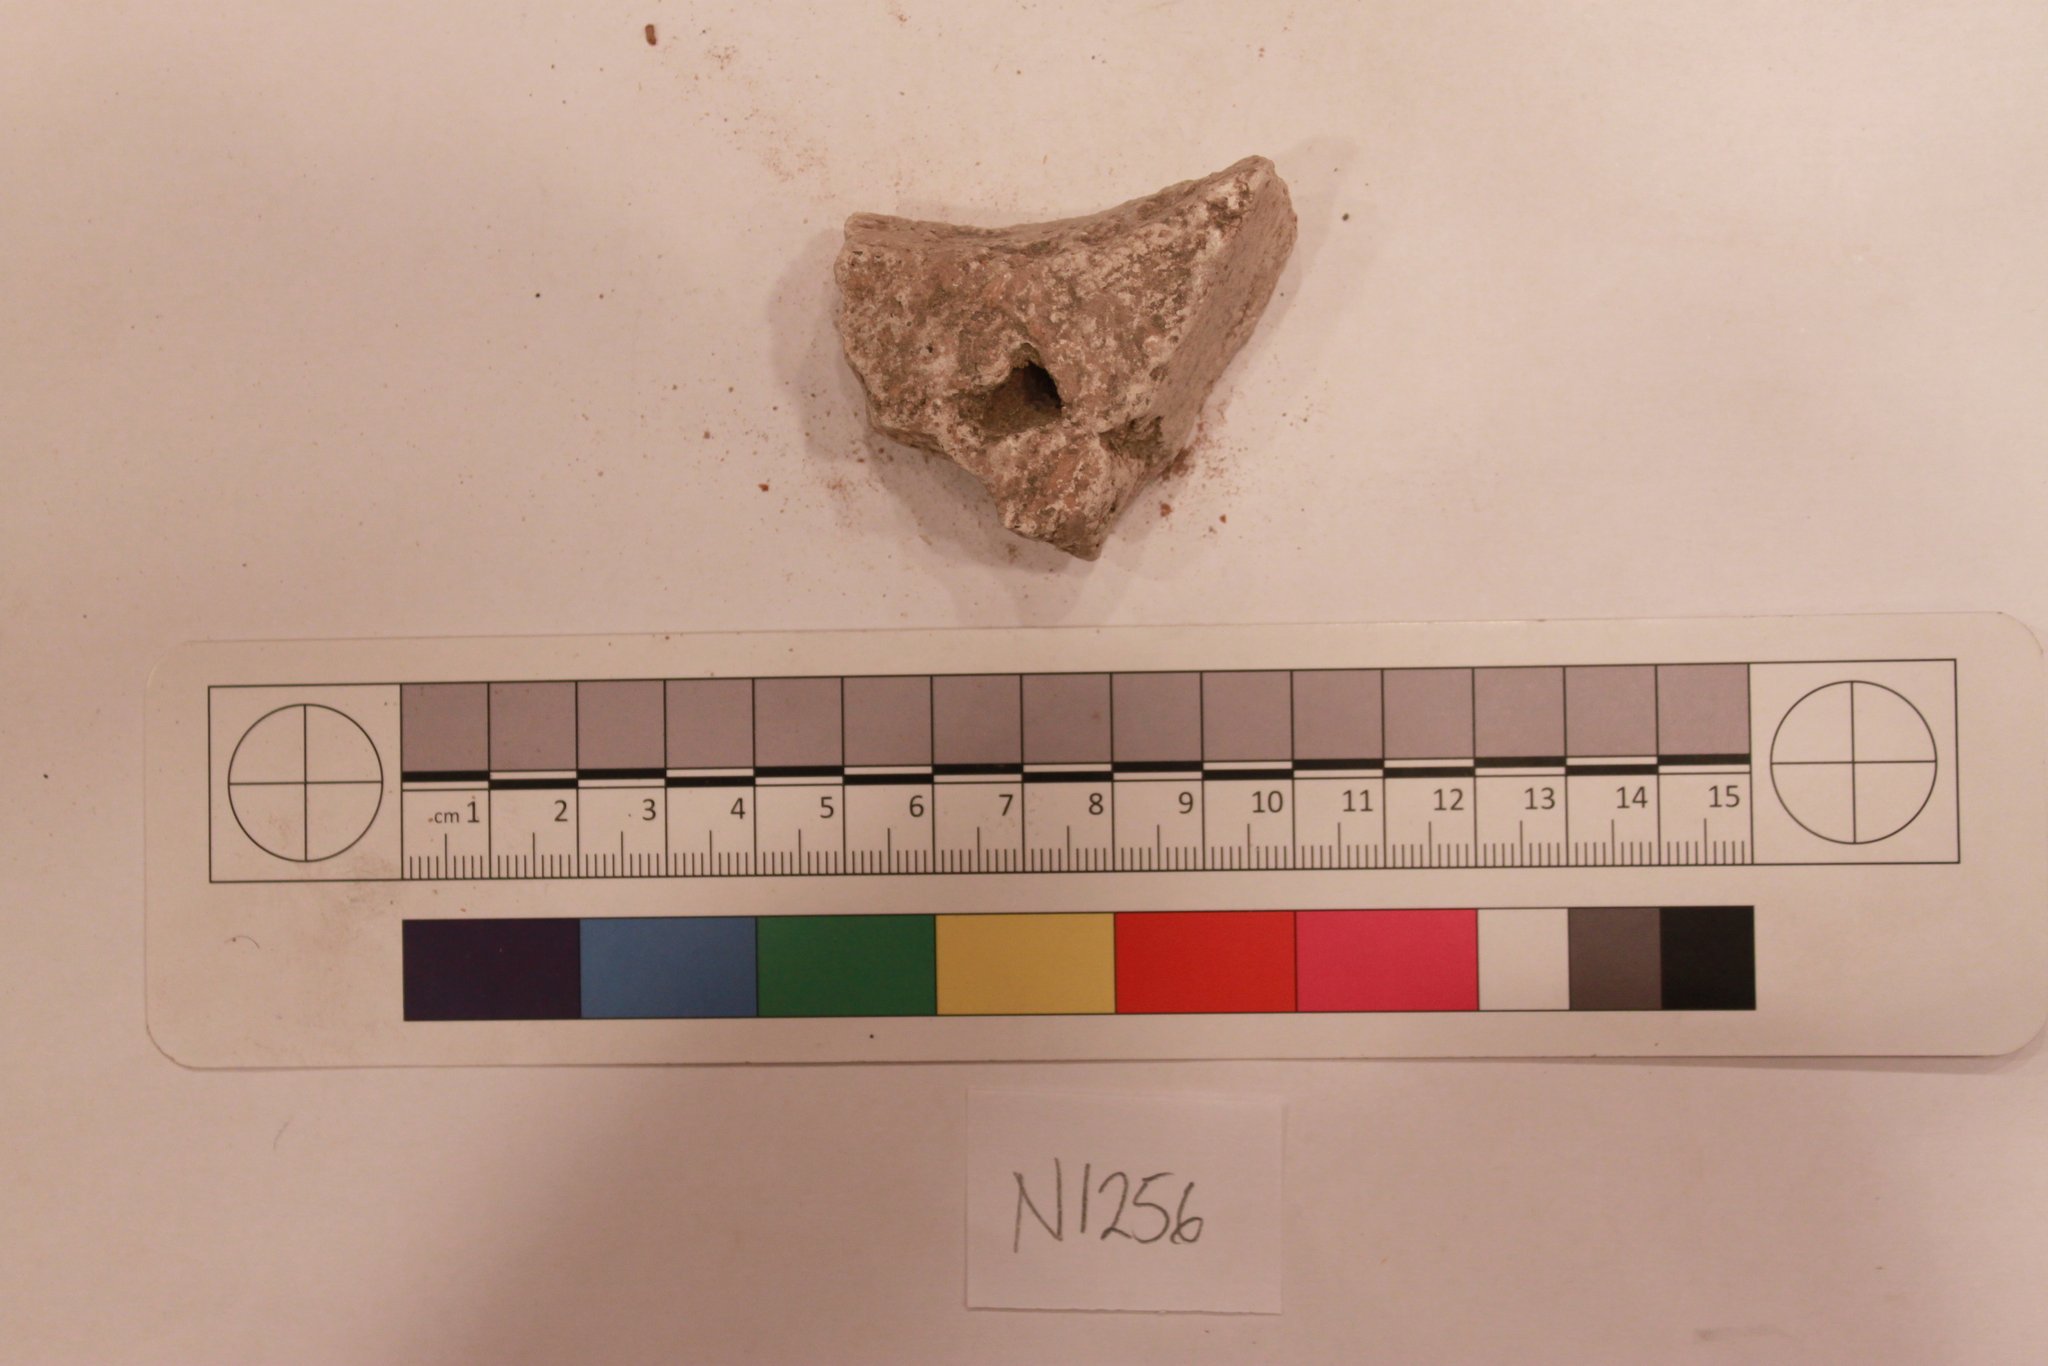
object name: fragment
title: Stucco Fragment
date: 701-1200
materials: plaster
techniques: carving, painting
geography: iran